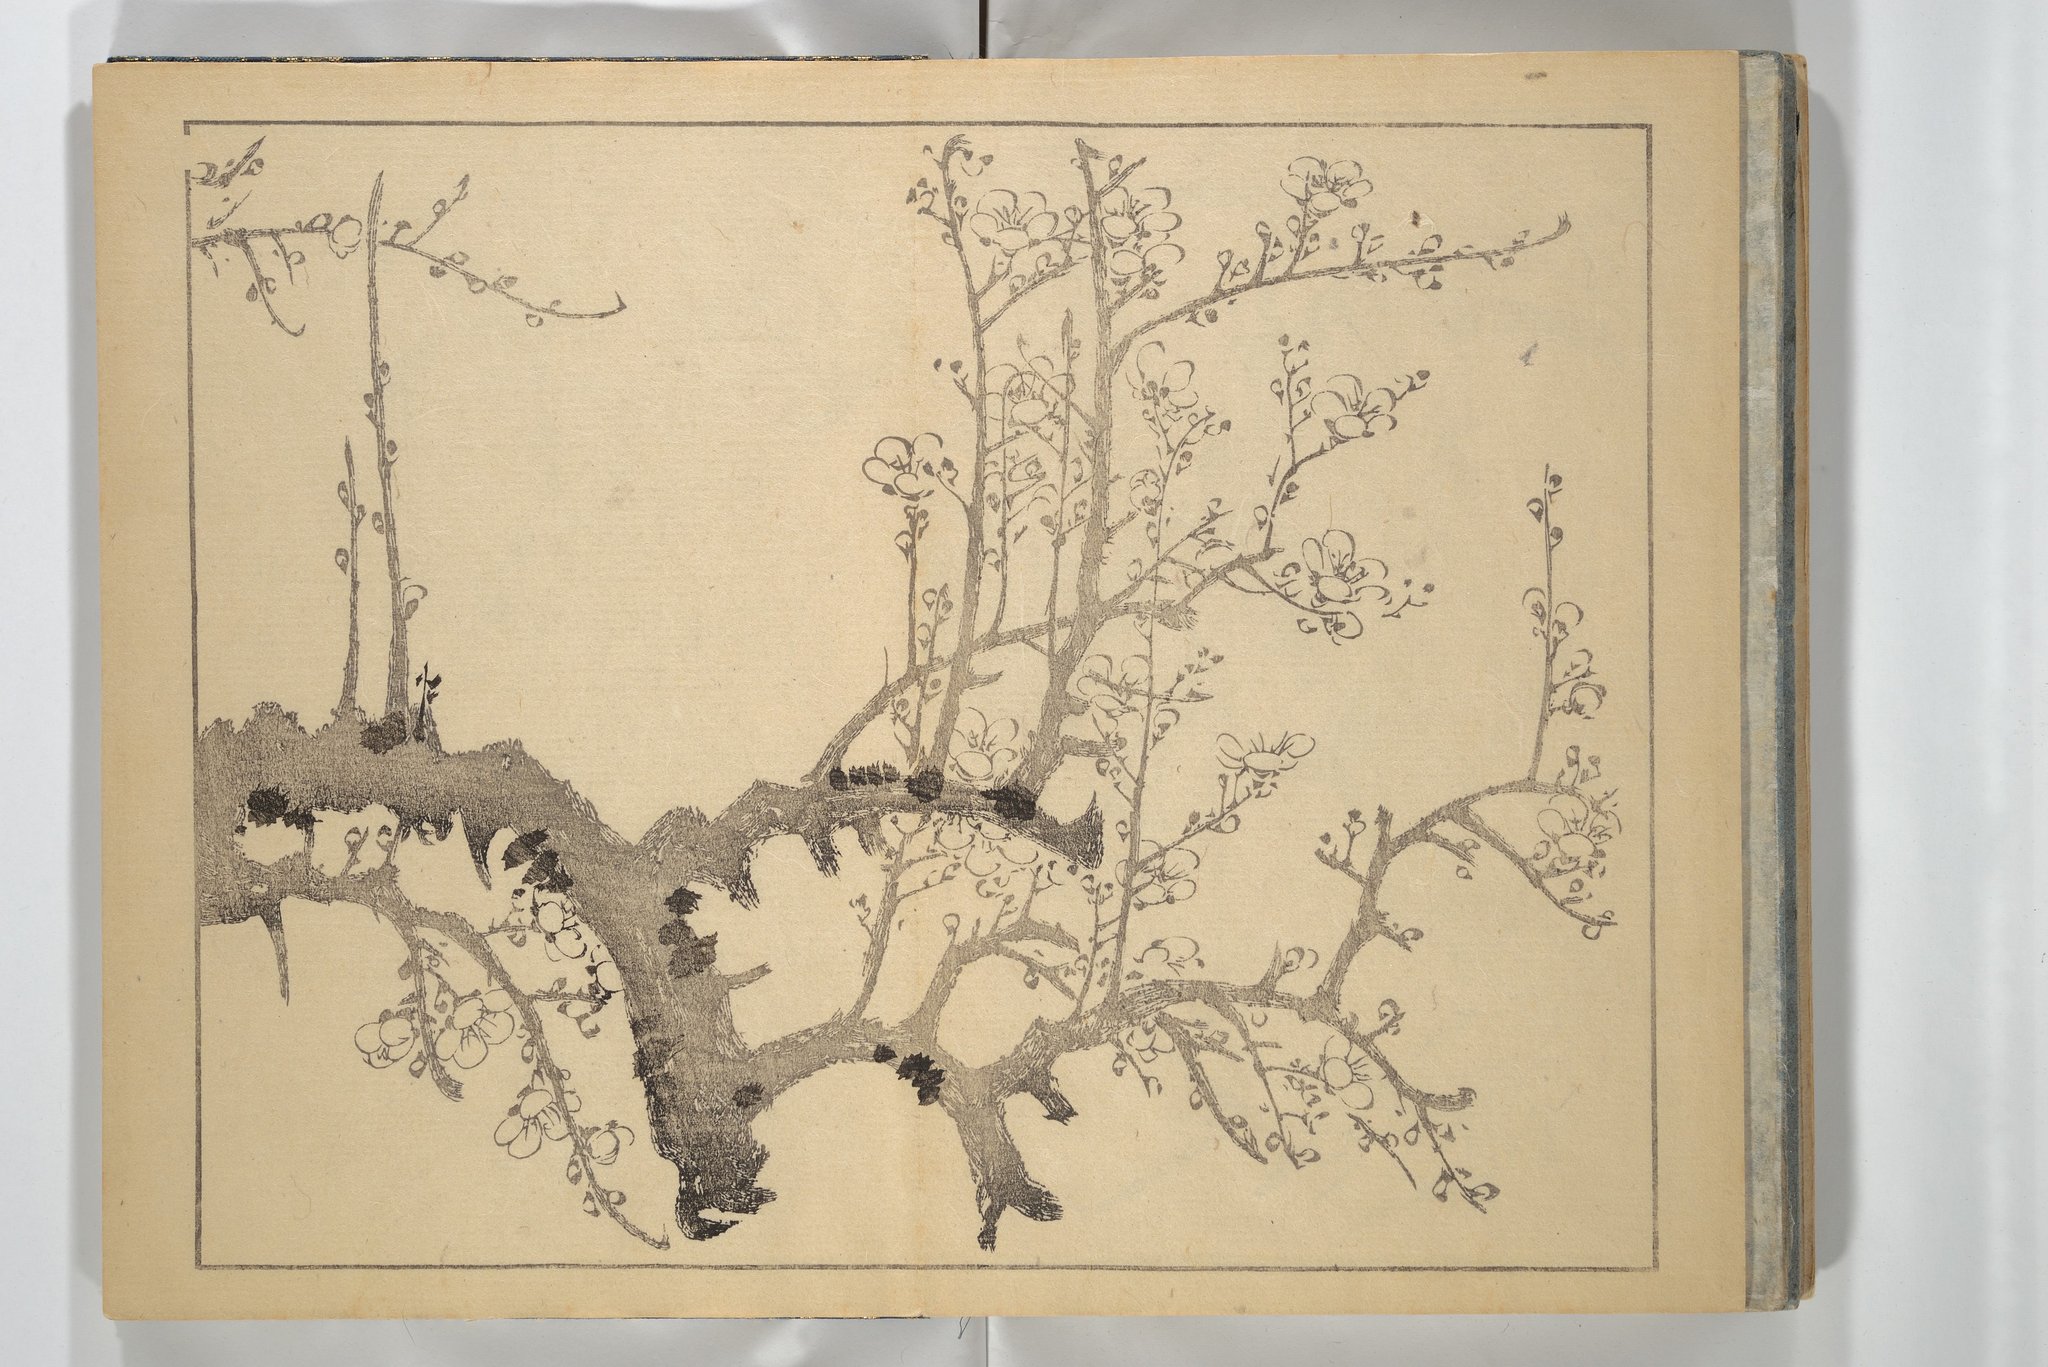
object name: illustrated book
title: The Four Worthies (Plum, Bamboo, Orchid, Chrysanthemum) (Shikunshi) 竹洞四君子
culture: japanese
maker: nakabayashi chikutō 中林竹洞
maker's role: artist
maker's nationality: japanese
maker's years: 1776-1853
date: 1853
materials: ink, paper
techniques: bookbinding, woodblock print